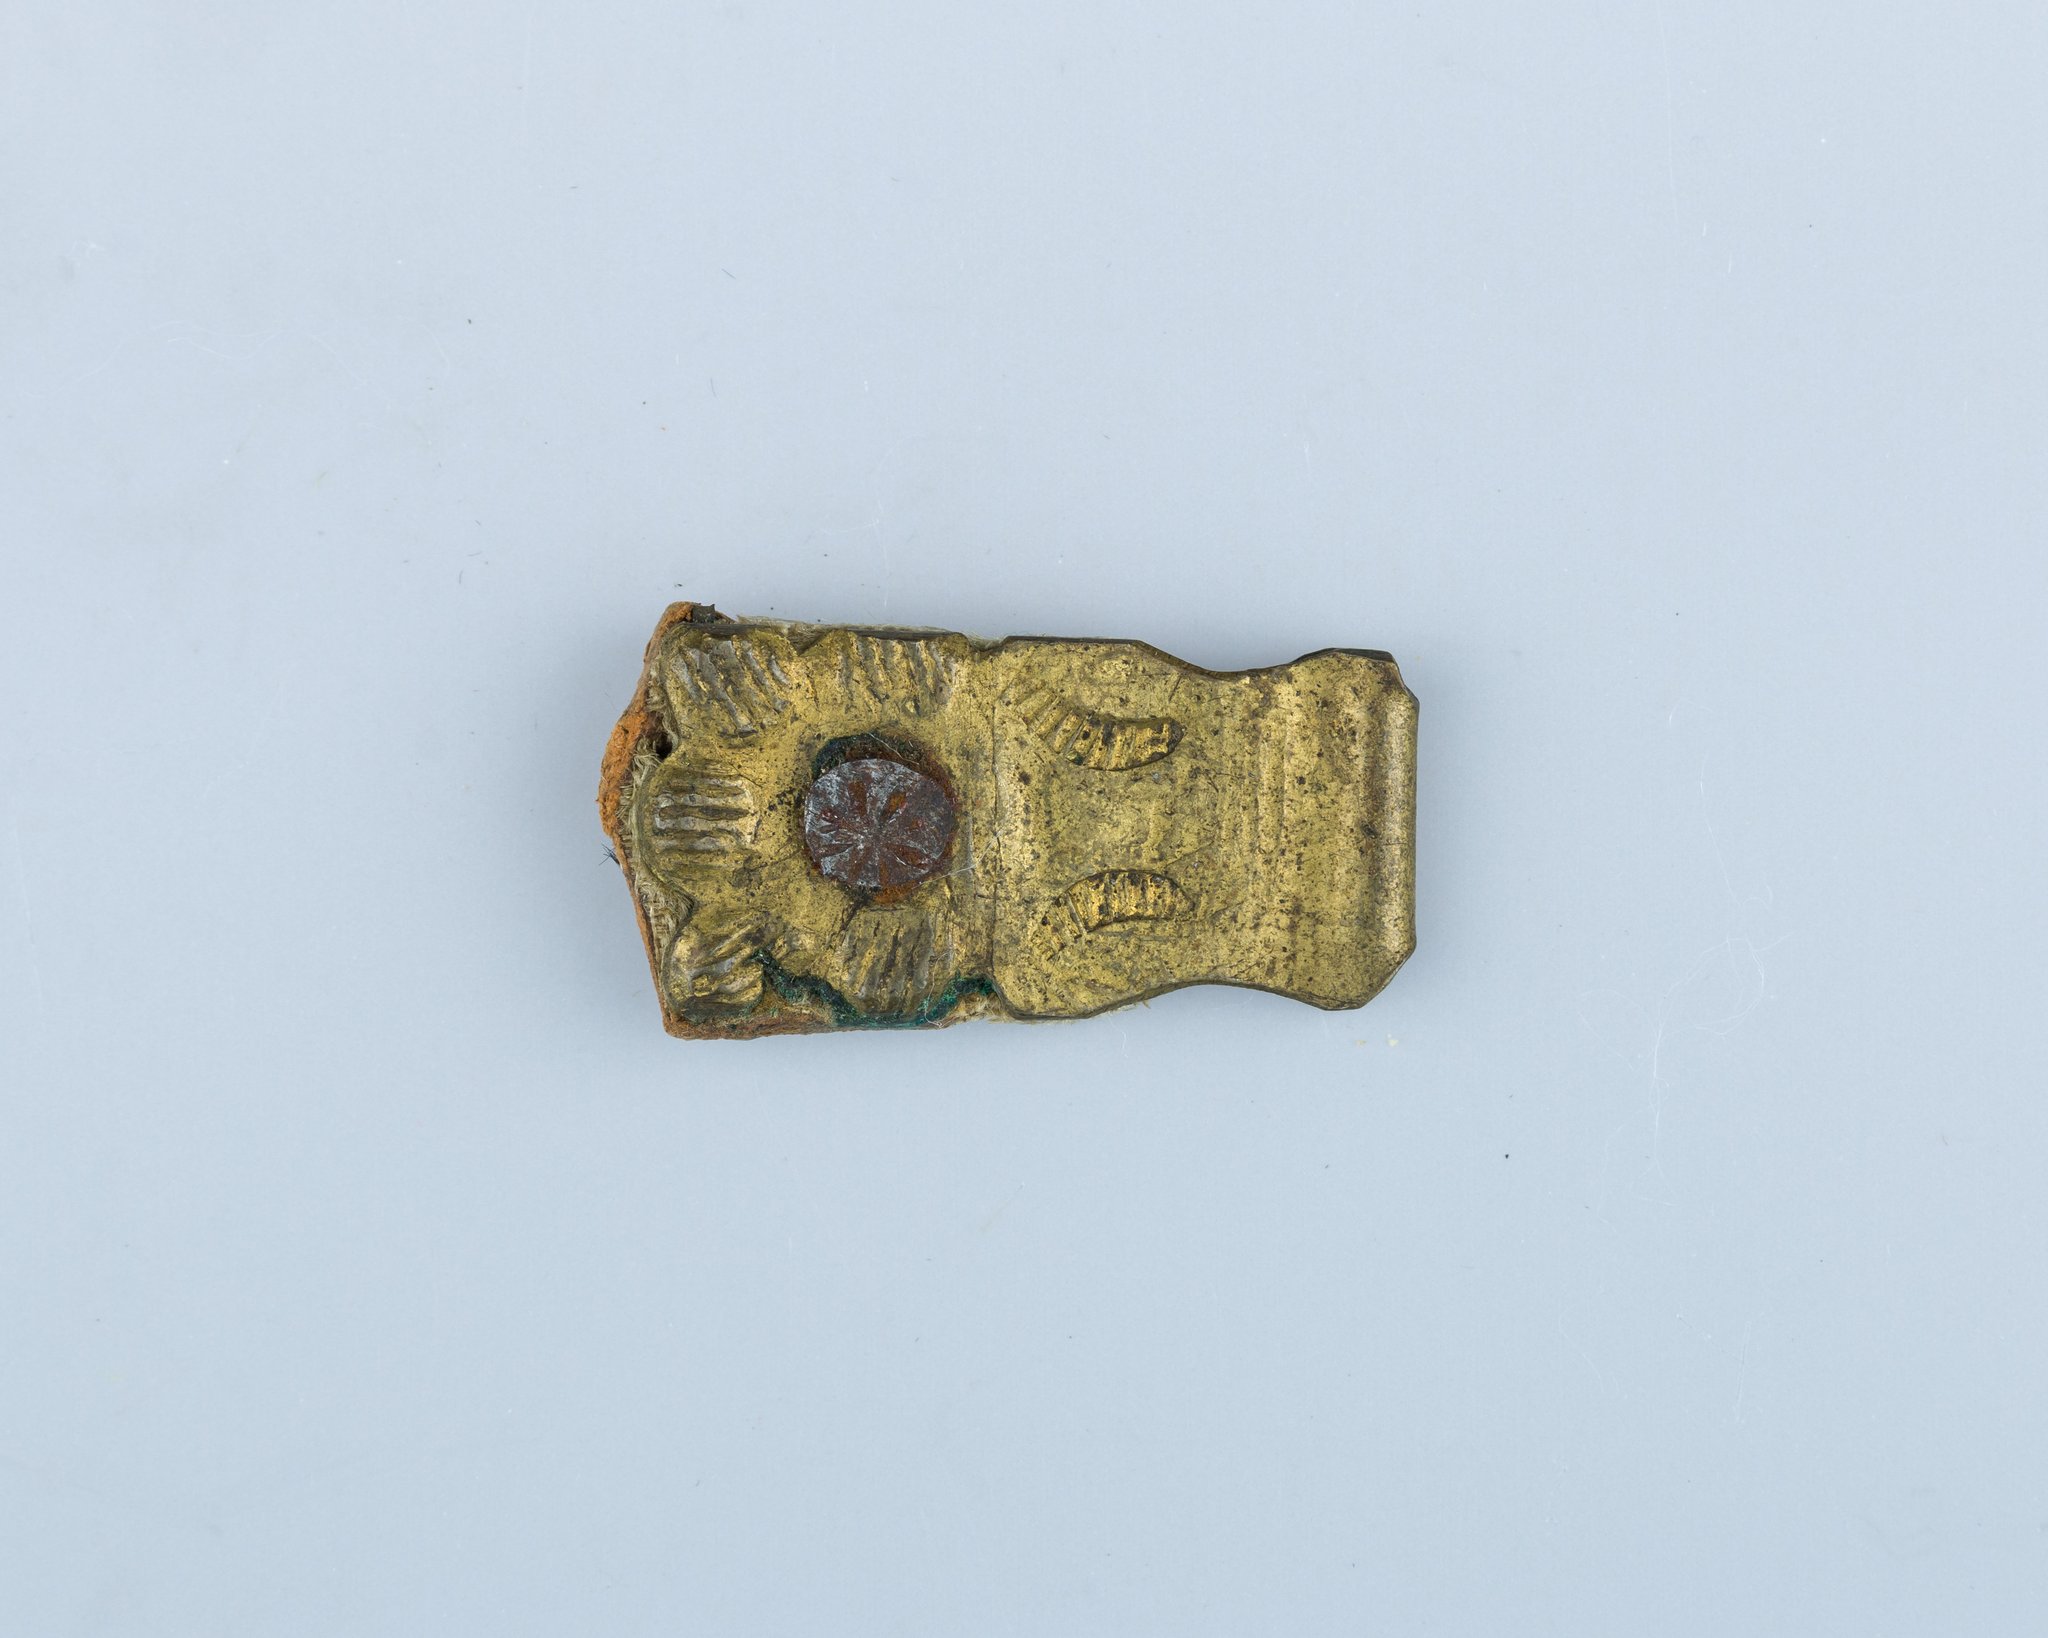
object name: mordant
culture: german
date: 1501-1600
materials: brass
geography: germany